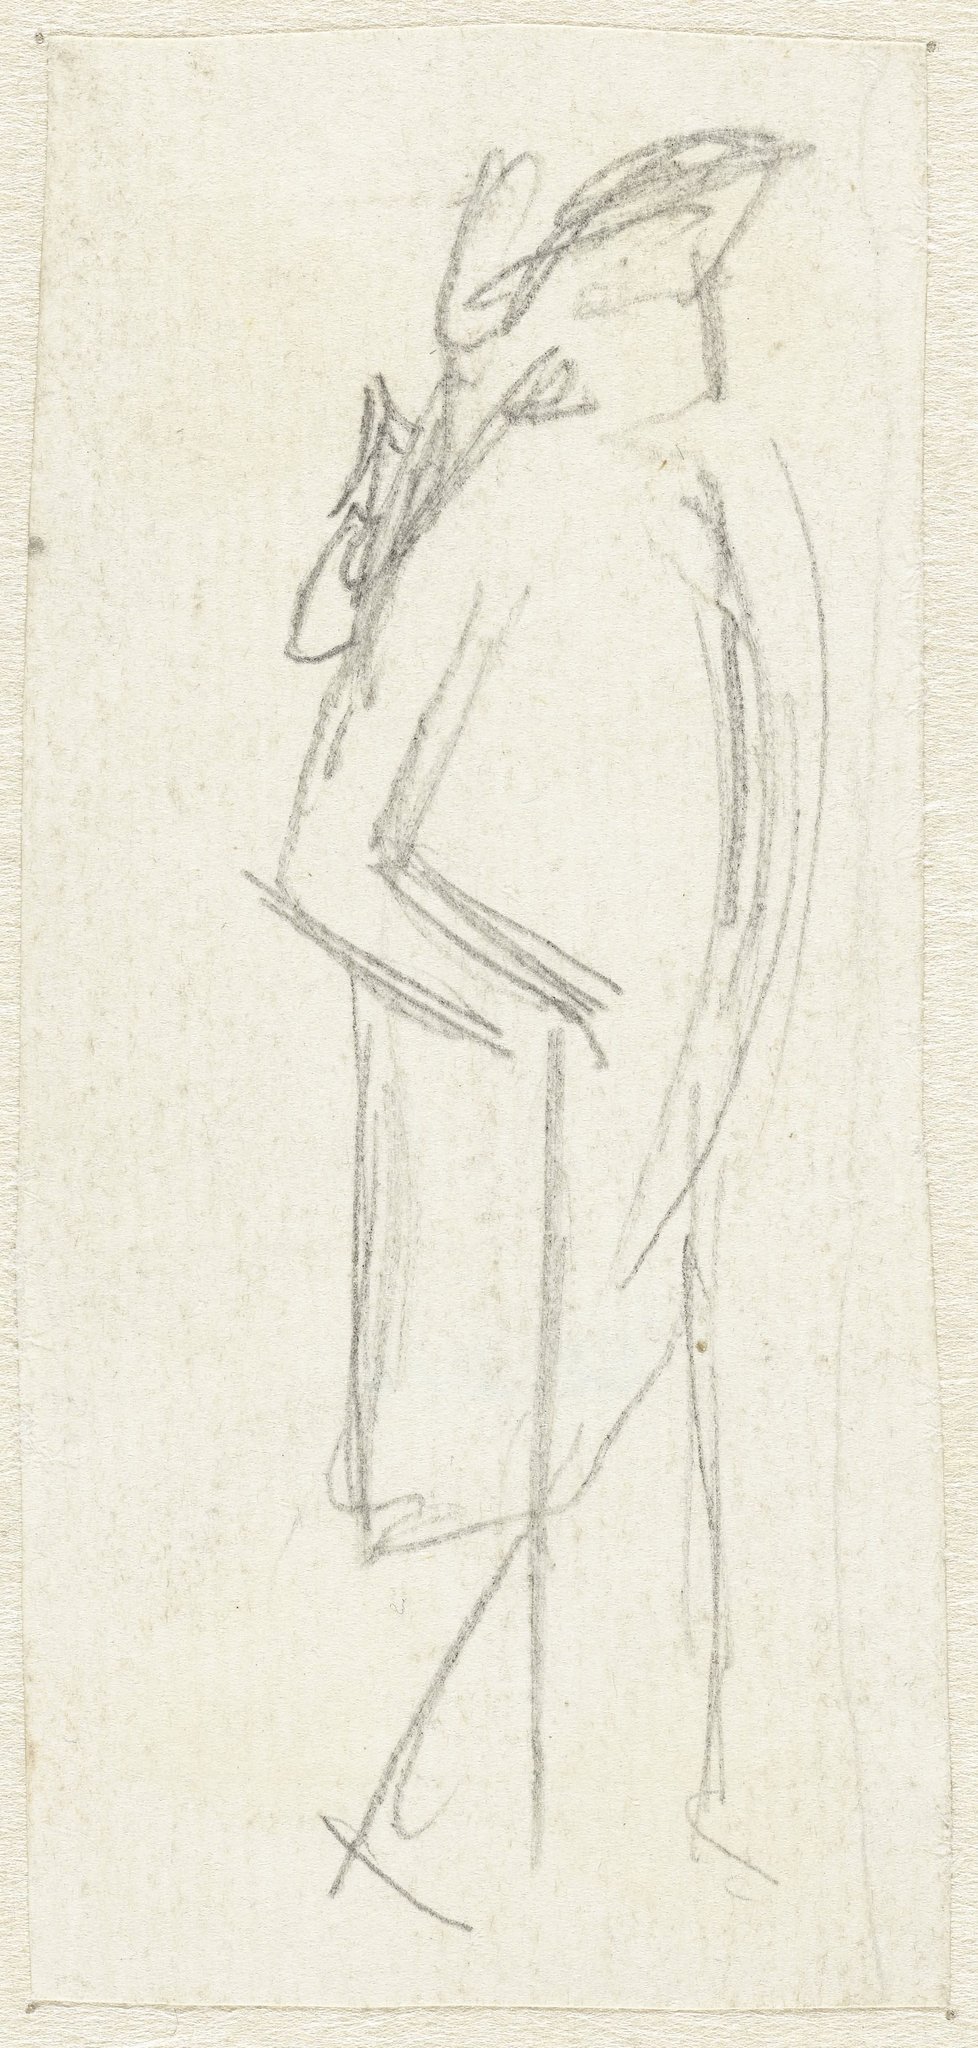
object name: drawing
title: Schets van een man, lopend naar rechts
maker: simon andreas krausz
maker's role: draughtsman, print maker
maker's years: 1760-1825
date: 1770-1825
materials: paper, pencil